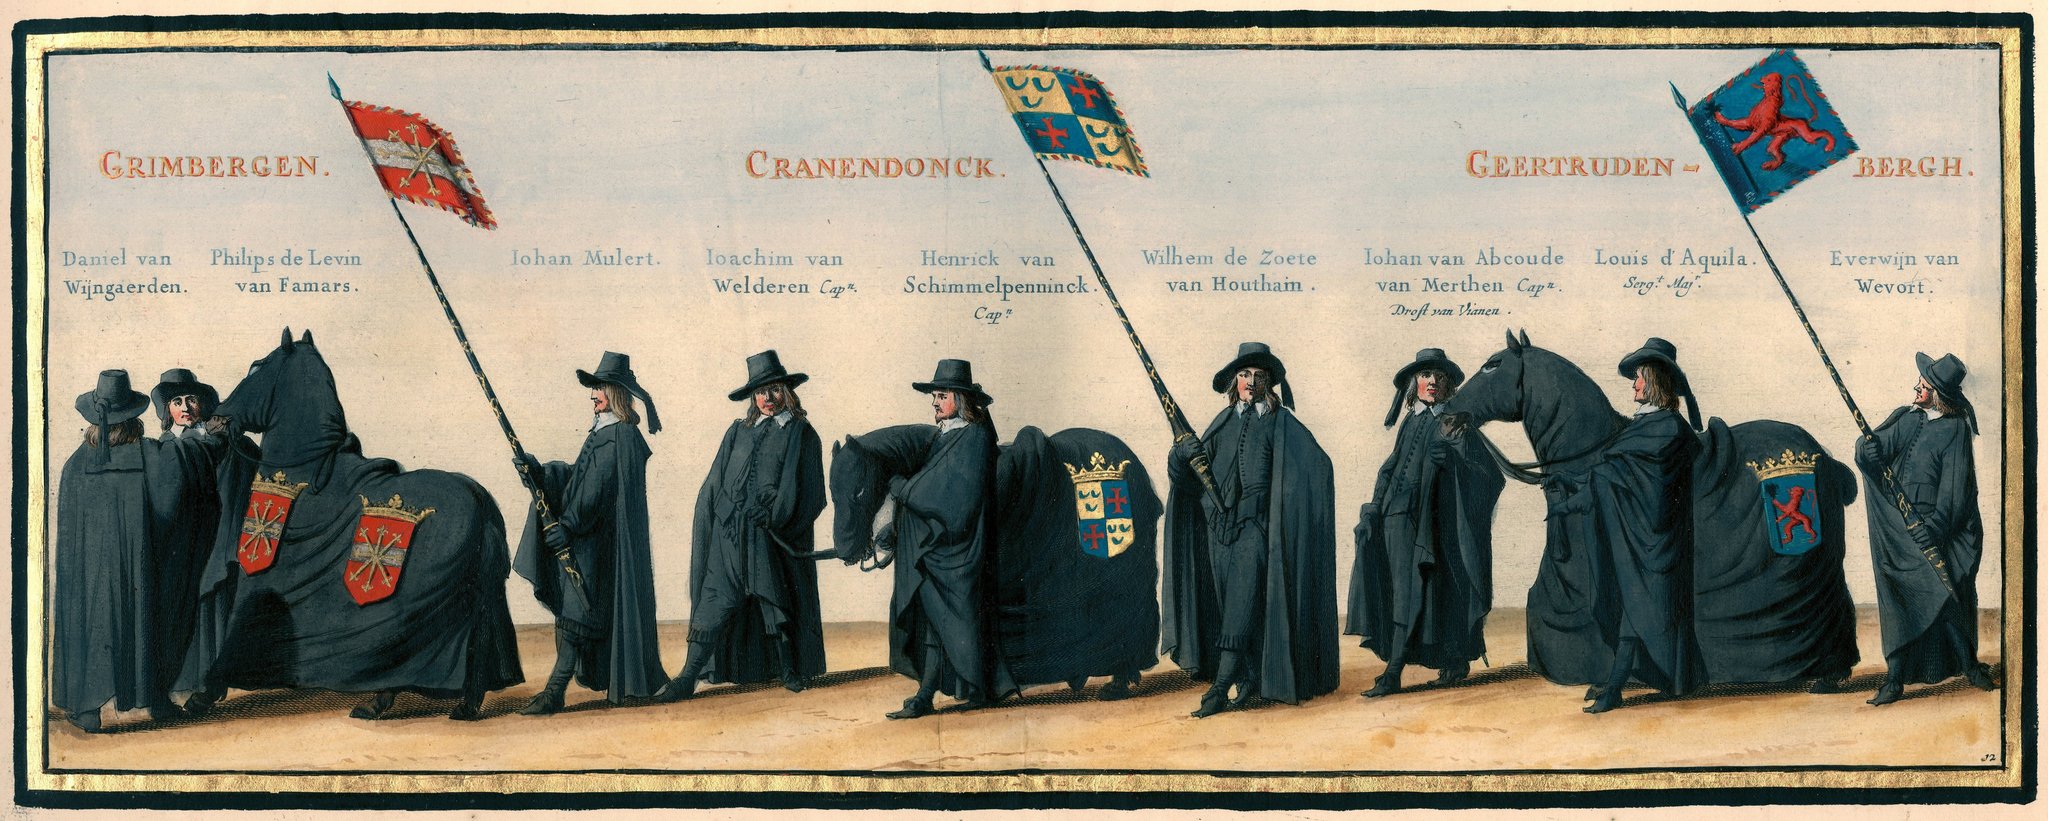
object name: book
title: Begraeffenisse van syne hoogheyt Frederick Henrick. Luxe ingekleurde uitgave van de prenten van de begrafenisstoet van Frederik Hendrik in 1647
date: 1651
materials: paint, paper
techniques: colour, etching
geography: amsterdam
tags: delft, the hague, frederick henry (prince of orange)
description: De begrafenisstoet van Frederik Hendrik, plaat nr. 12. Ingekleurde prent in een omlijsting versierd met goud en ingeplakt in de luxe editie uit ca. 1755 van het boek 'Begraeffenisse van syne hoogheyt Frederick Henrick' van Pieter Post, uitgegeven te Amsterdam in 1651.